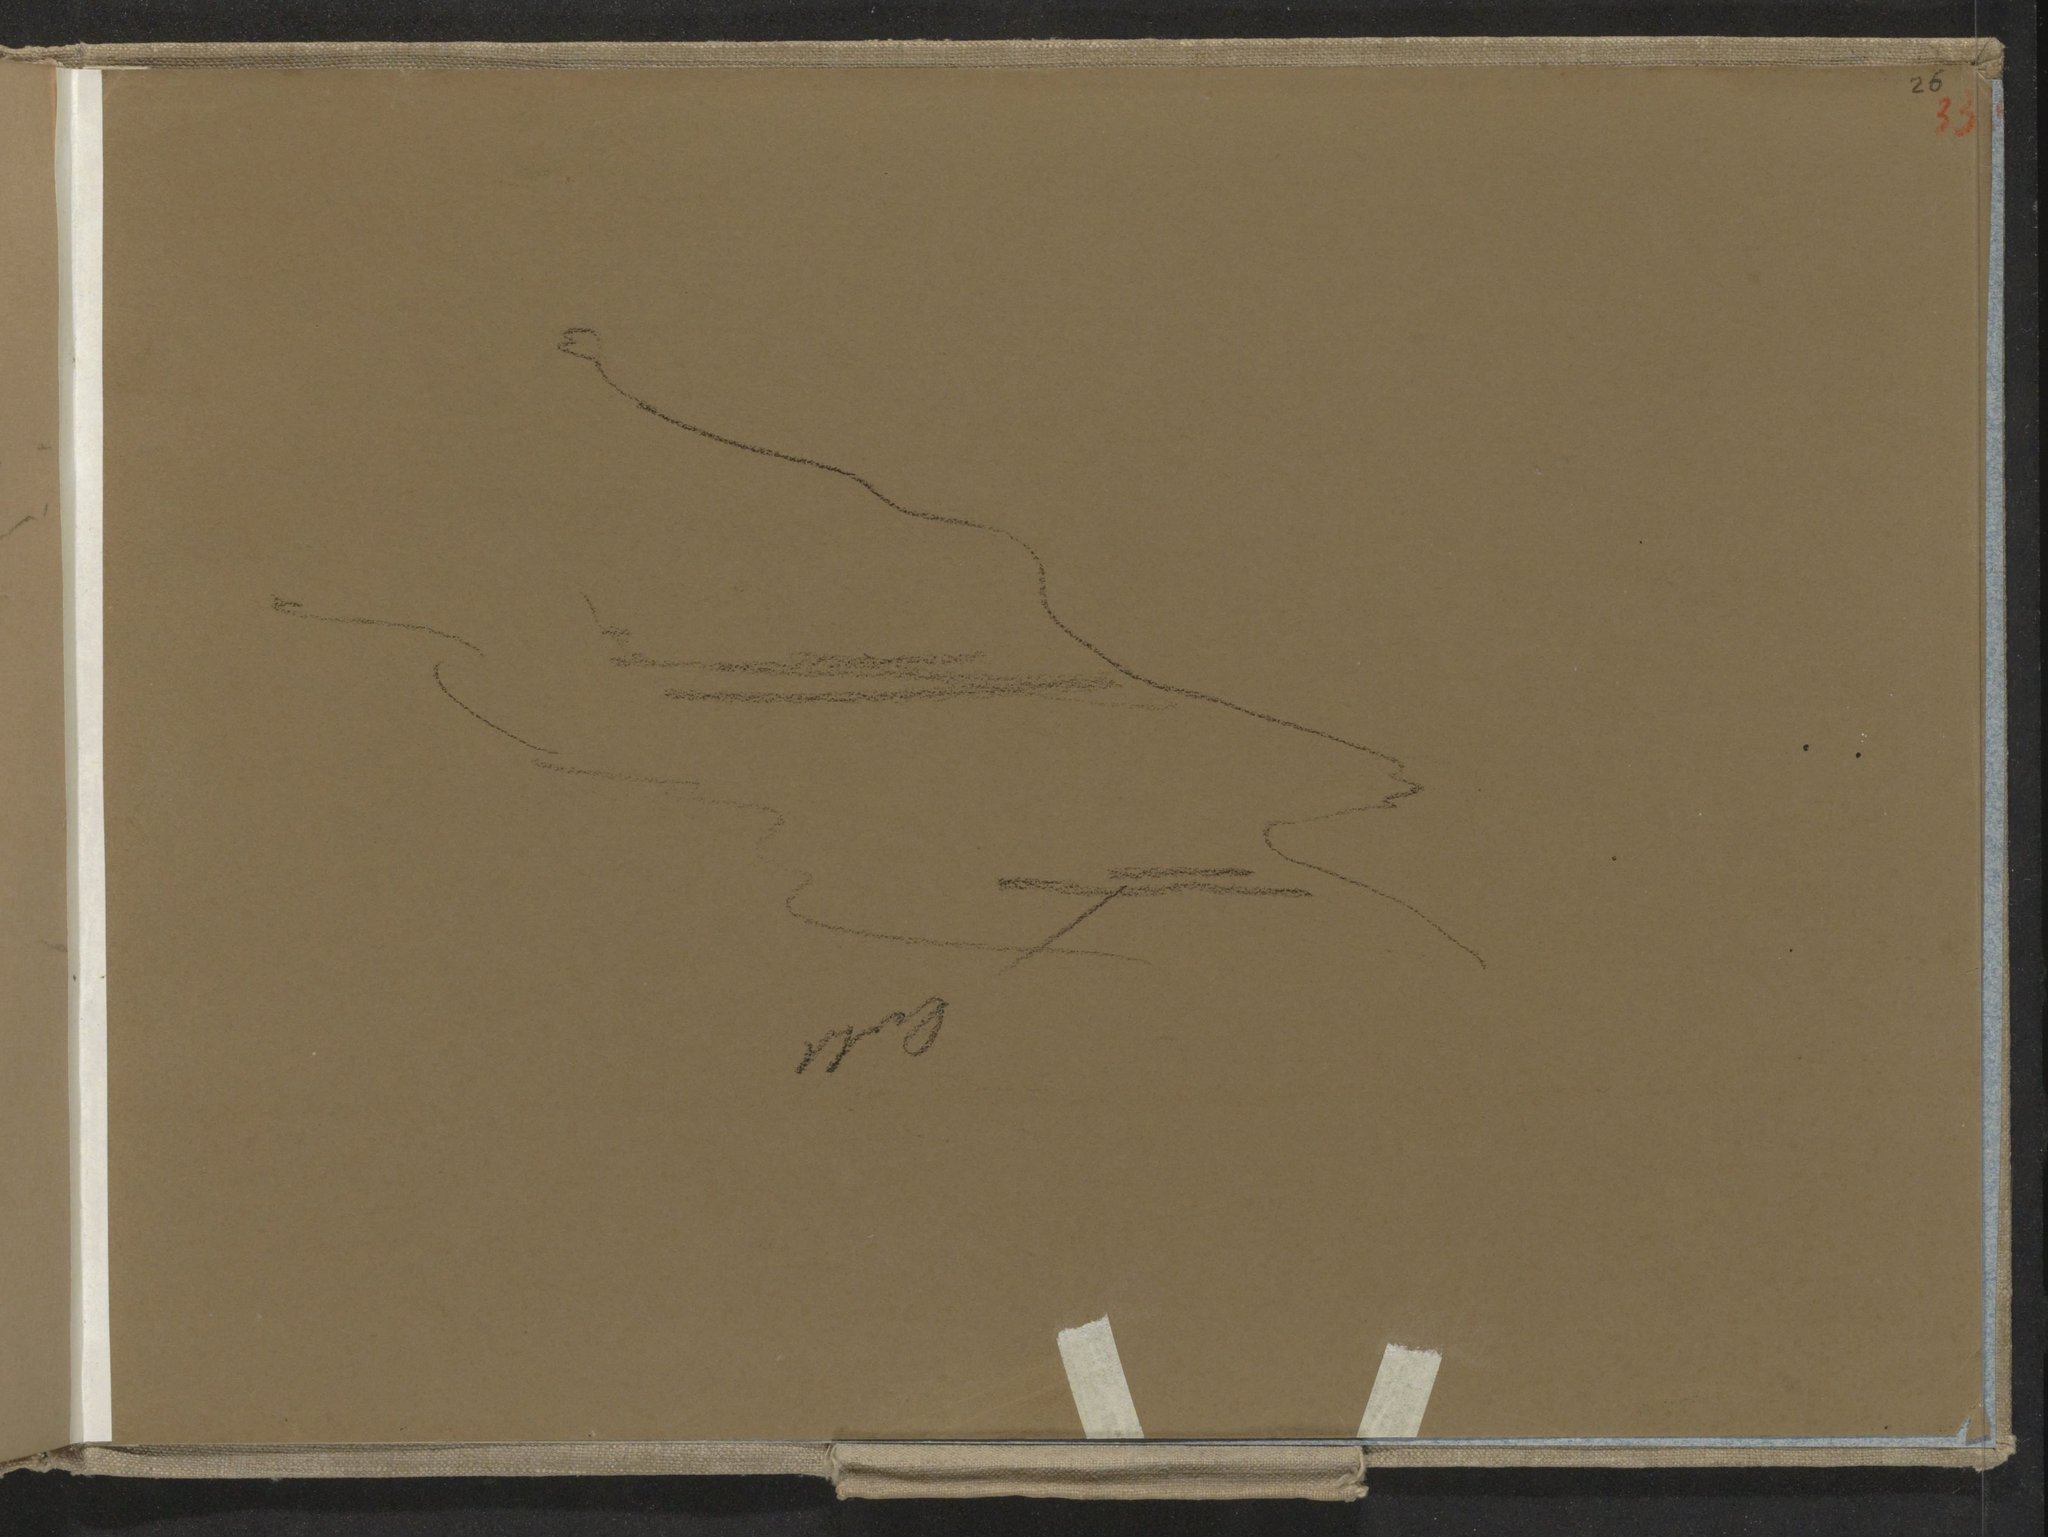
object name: sketchbook leaf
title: Studie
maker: jozef israëls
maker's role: draughtsman, painter, print maker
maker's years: 1824-1911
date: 1834-1911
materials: chalk, paper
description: Blad 26 recto uit een schetsboek met 27 bladen.